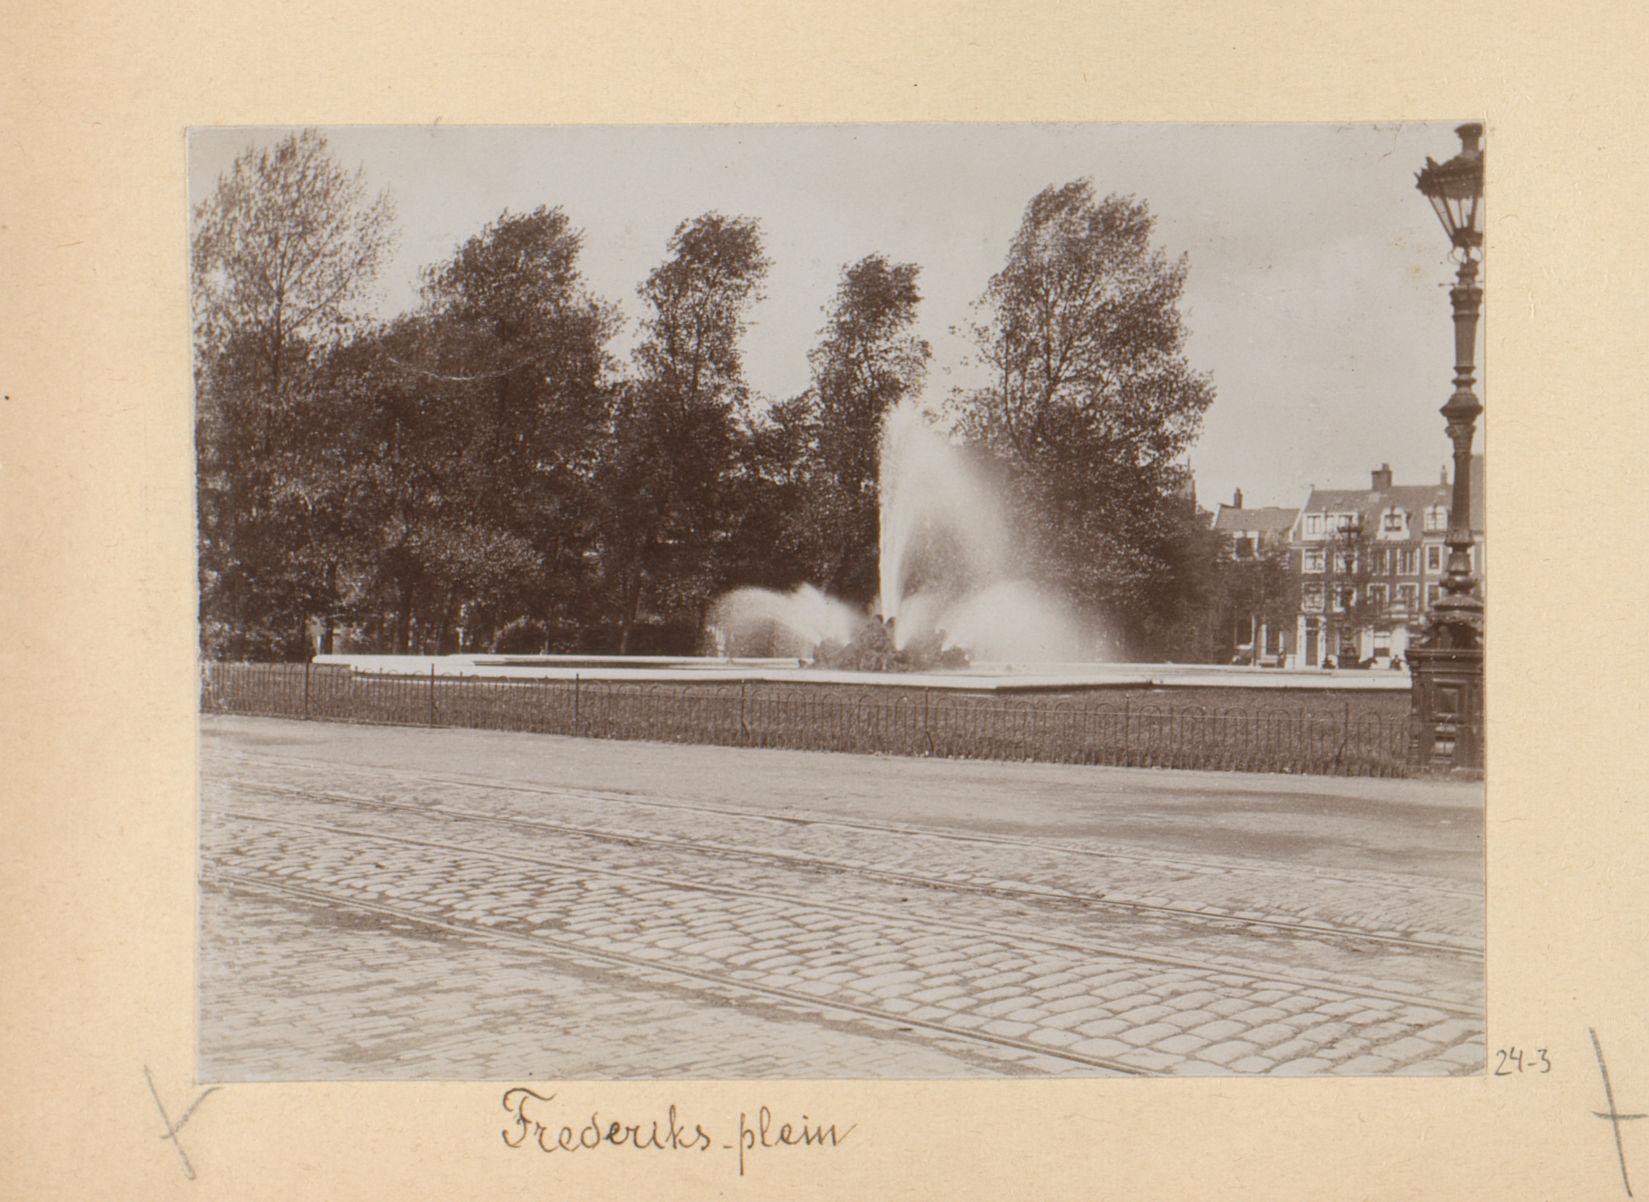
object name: album leaf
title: Frederiksplein te Amsterdam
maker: hendrik herman van den berg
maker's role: amateurfotograaf, jurist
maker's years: 1875-1944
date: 1890-1894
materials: paper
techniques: collodion silver print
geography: amsterdam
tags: square, place, circus, etc., ornamental fountain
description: Foto 3 op albumblad 24 uit album "Amsterdam 1890-1894".